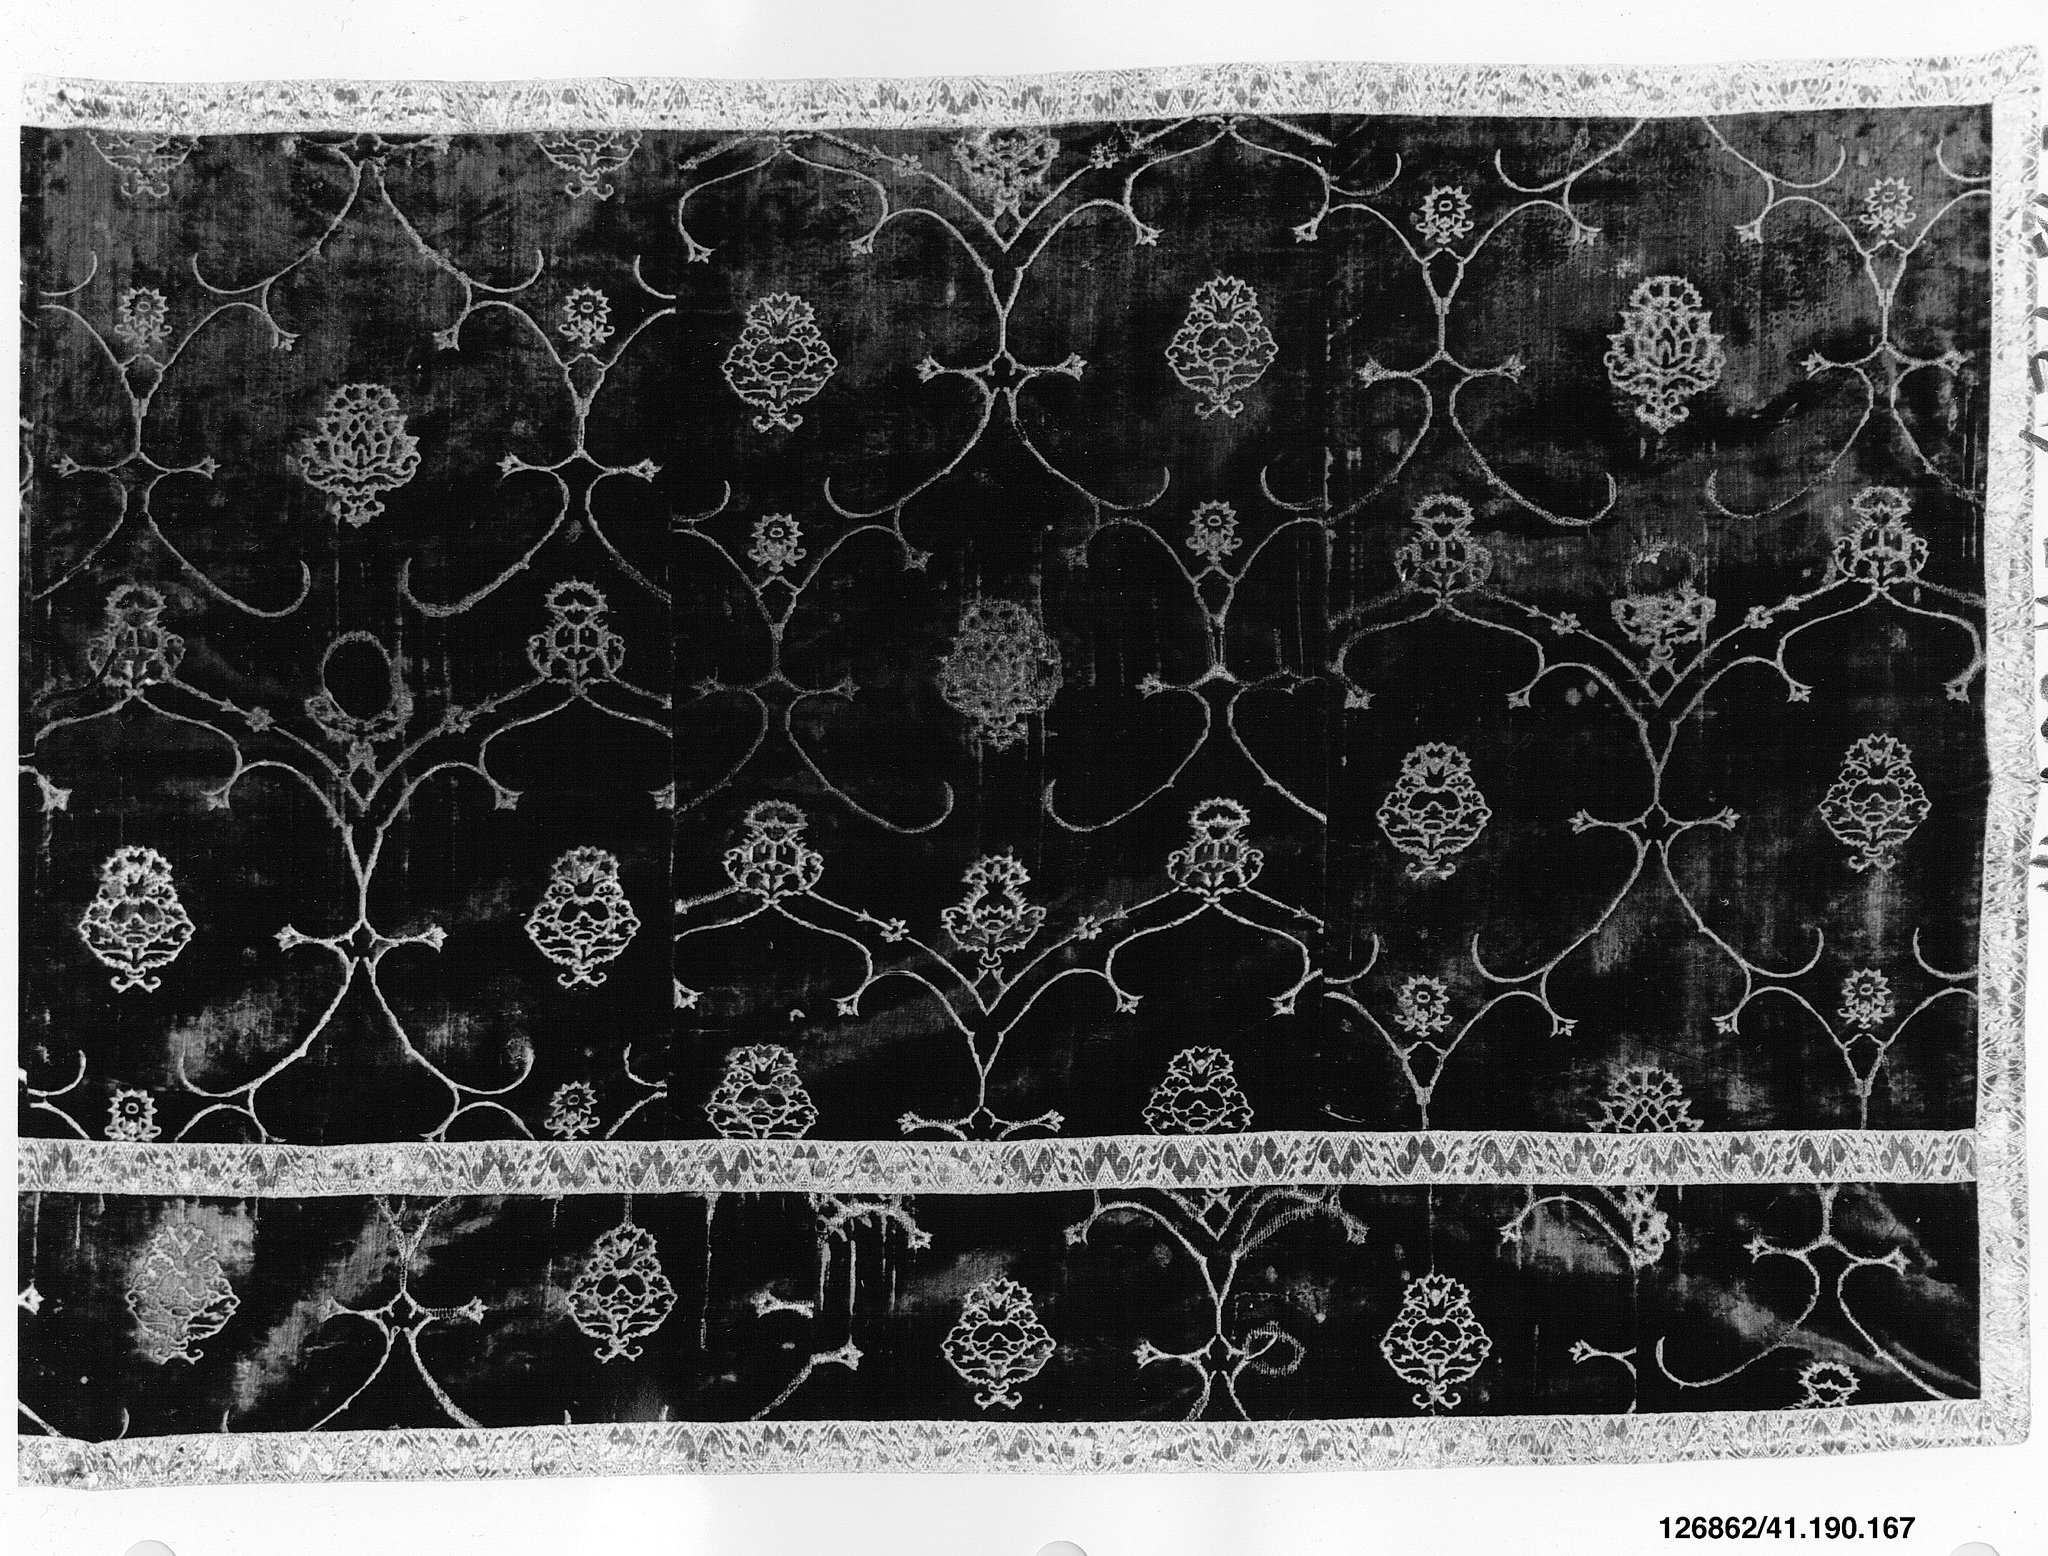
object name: panel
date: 1467-1500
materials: silk